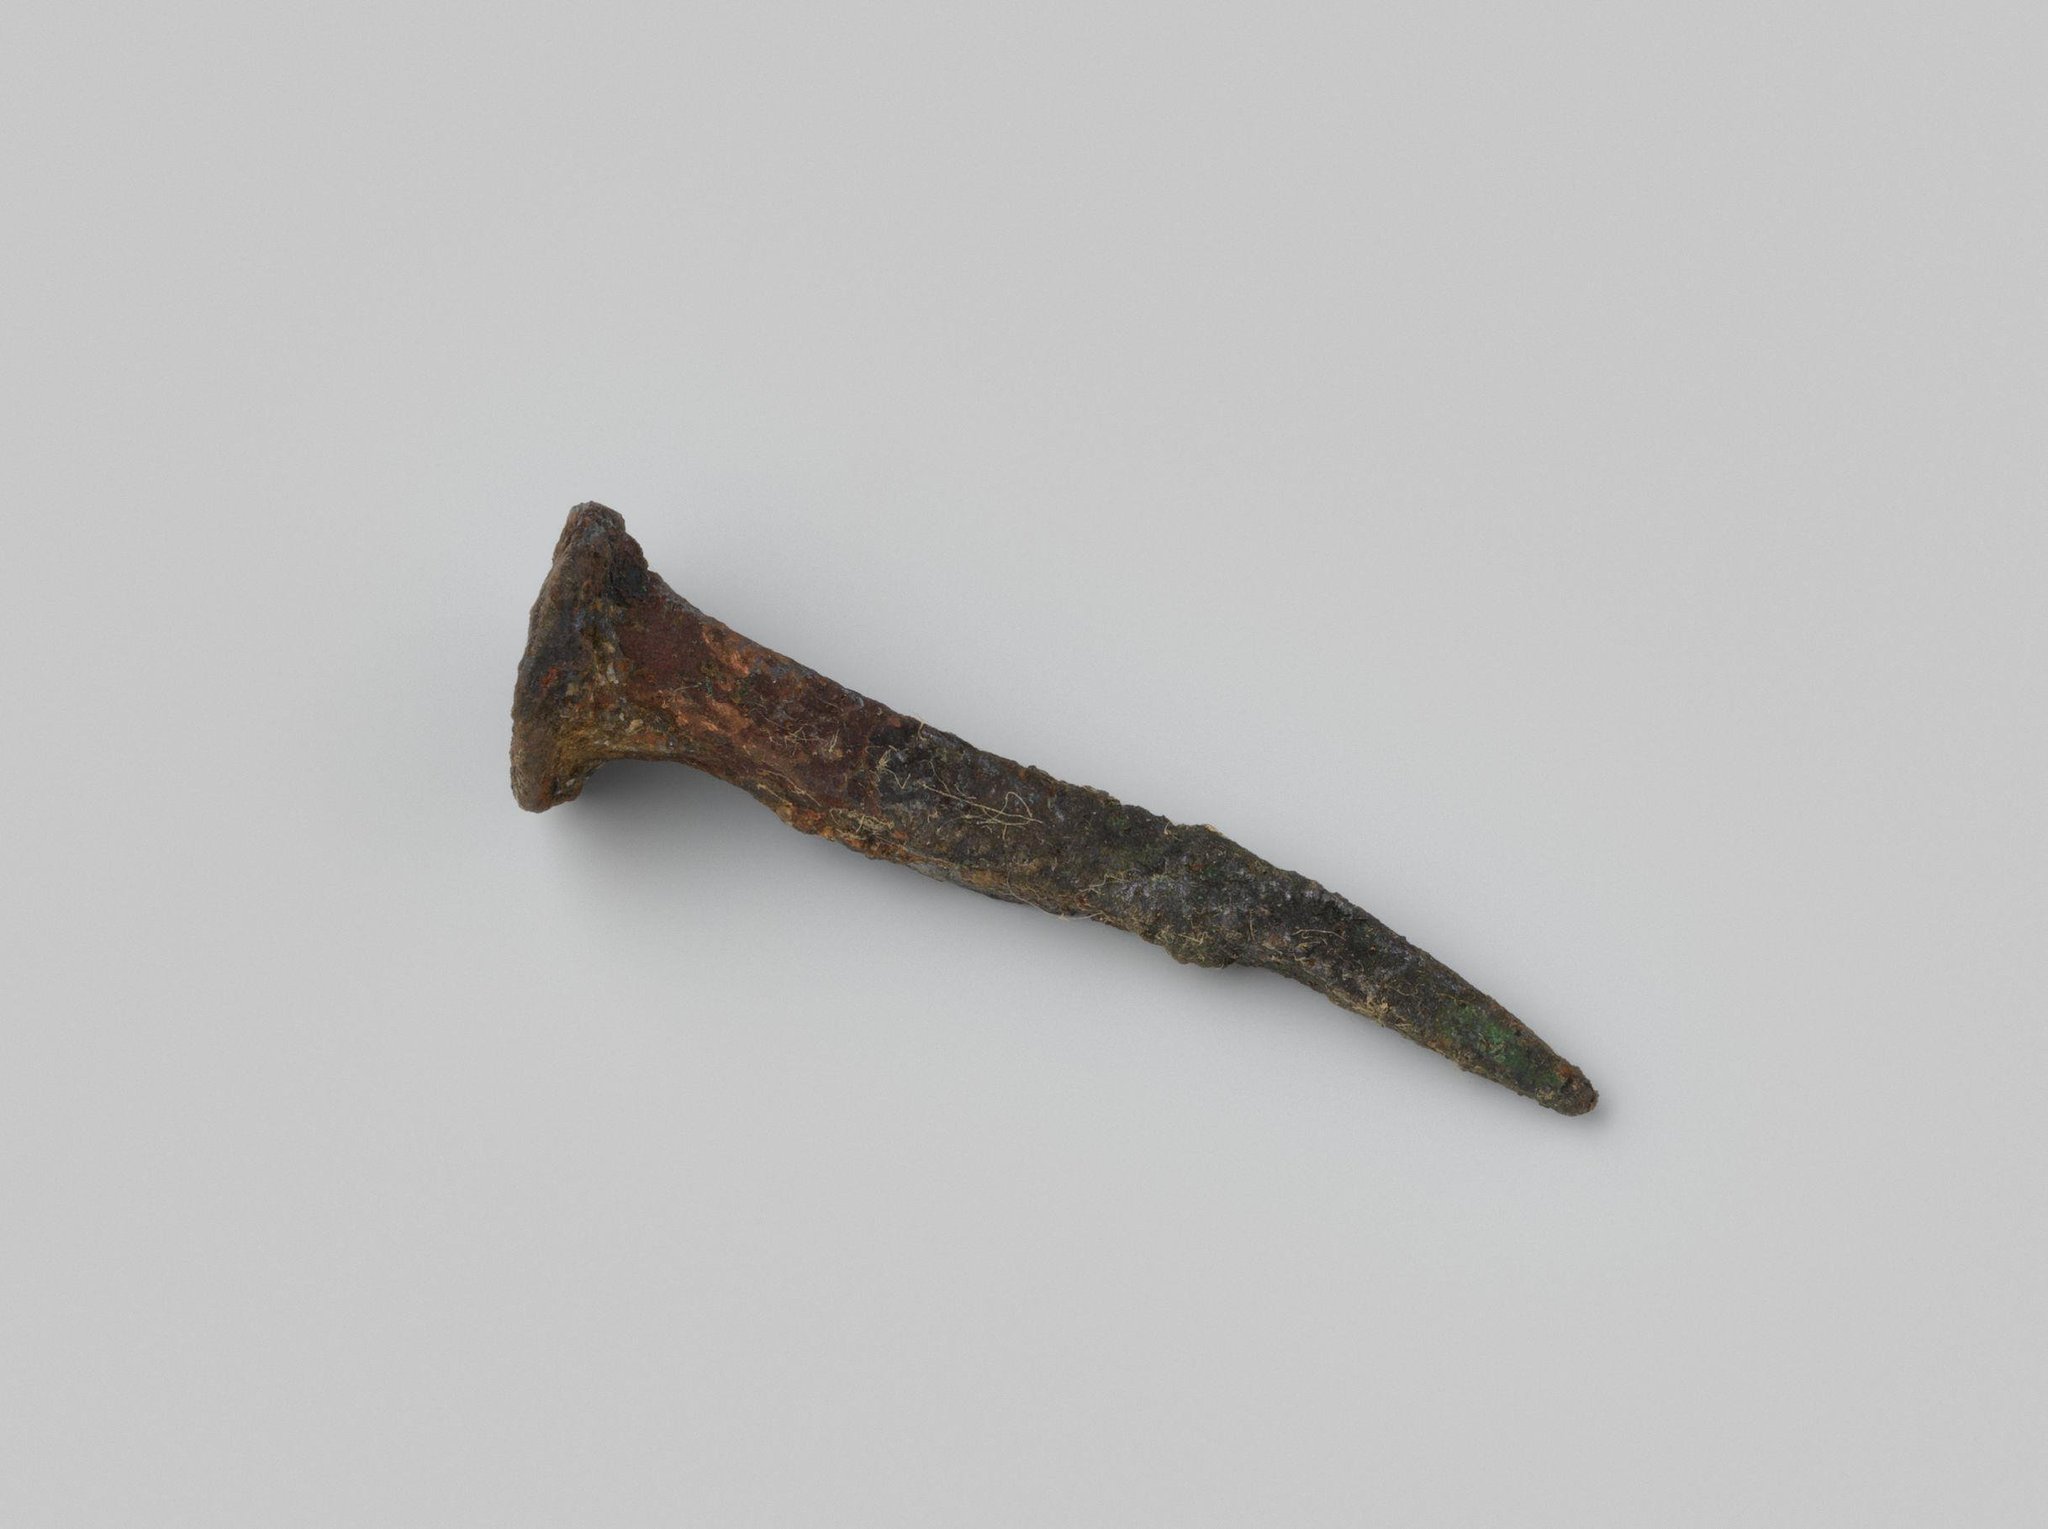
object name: nagel, spijker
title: Spijker afkomstig uit het wrak van de Oost-Indiëvaarder Hollandia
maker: Anonymous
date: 1700-1743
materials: iron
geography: netherlands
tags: verenigde oostindische compagnie, hollandia (schip)